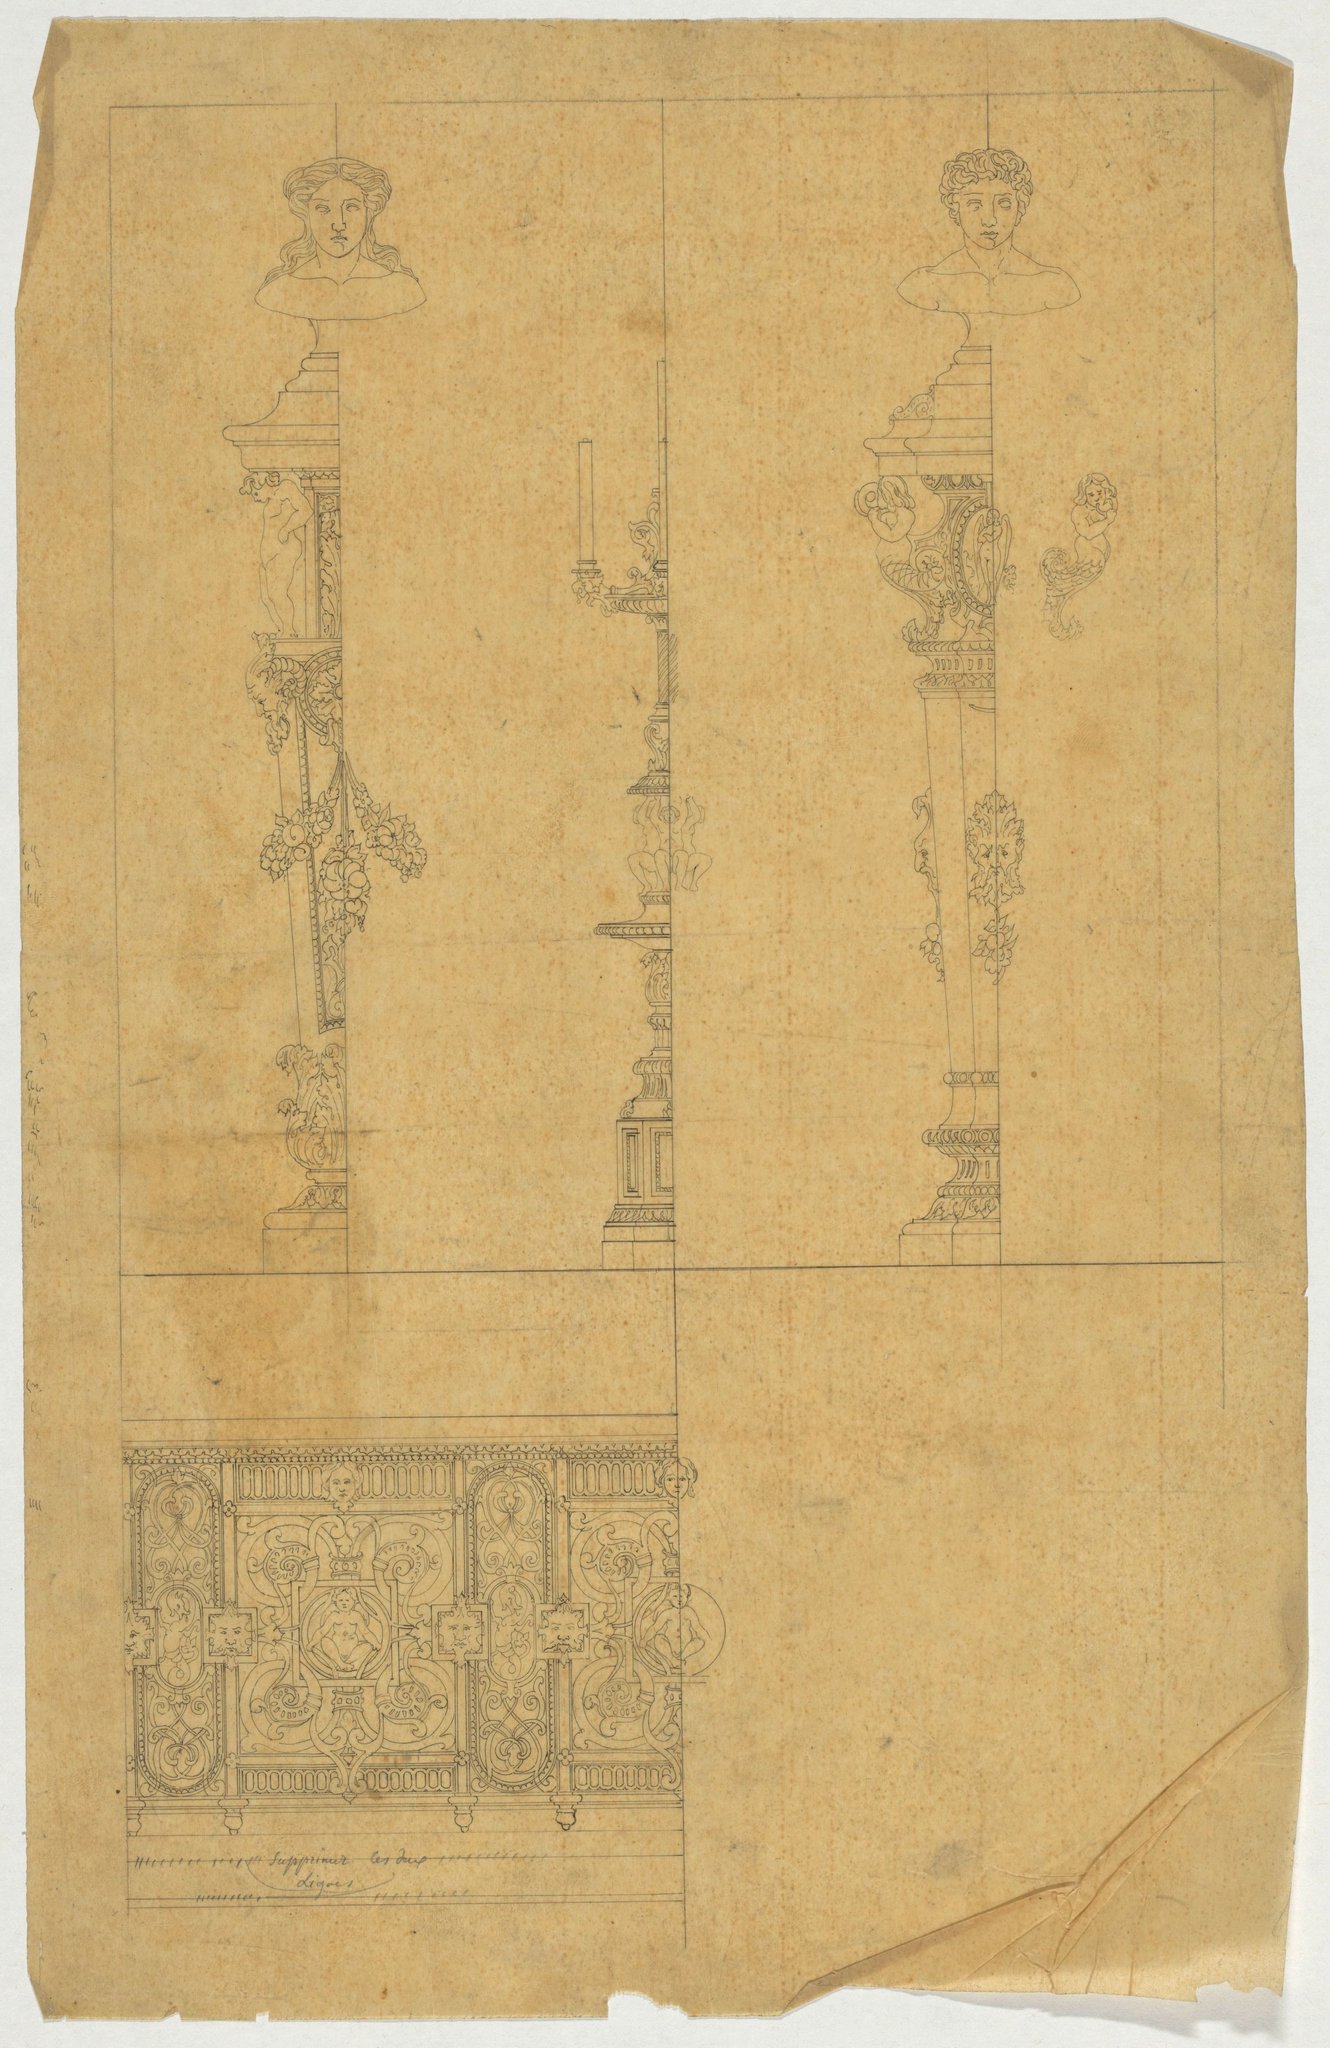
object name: design drawing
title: Sokkels, kandelaar en balkonhek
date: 1830-1850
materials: paper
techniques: pen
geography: paris